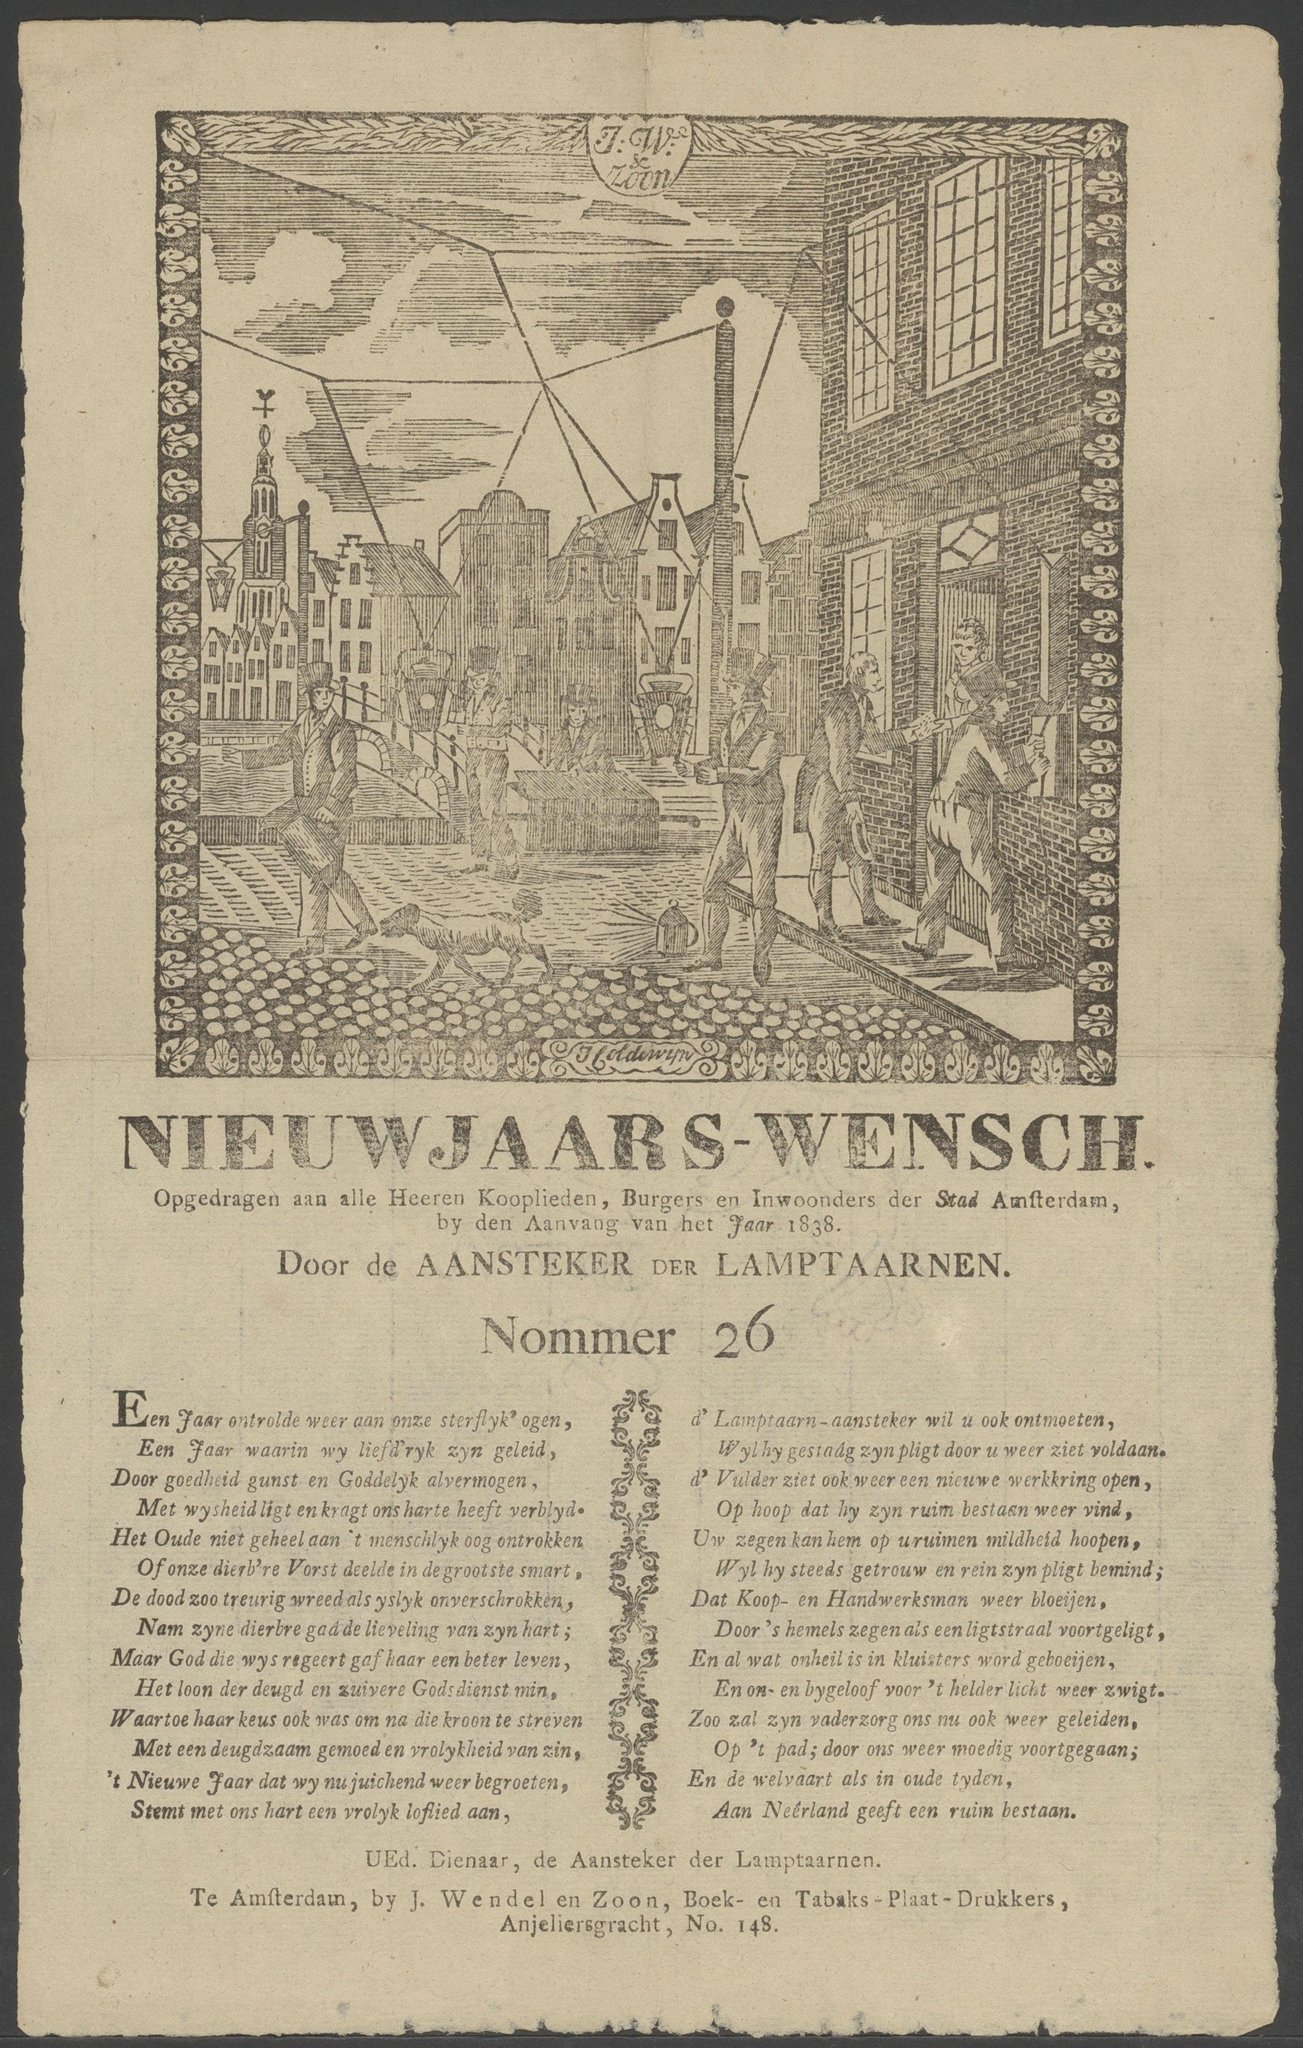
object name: print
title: Nieuwjaarswens van de Amsterdamse lantaarnopstekers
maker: jacob coldewijn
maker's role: print maker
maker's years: 1796-1855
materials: paper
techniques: letterpress printing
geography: amsterdam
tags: government services, public services, lantern, street lighting, amsterdam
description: Nieuwjaarswens van de Amsterdamse lantaarnopstekers en vullers, van 1838. Gezicht in een straat in Amsterdam waar enkele mannen bezig zijn de straatlantaarns te vullen en aan te steken. Een andere man haalt geld op bij een huis. Met een vers in twee kolommen. Van de lantaarnopstekers in de wijk no. 26. Onderwerpsrubrieken binnen de Atlas Zeden en Gewoonten: Zeden en gewoonten in engeren zin, Volksleven, Volksbladen, Nieuwjaars- en Kerstwenschen, Amsterdam.